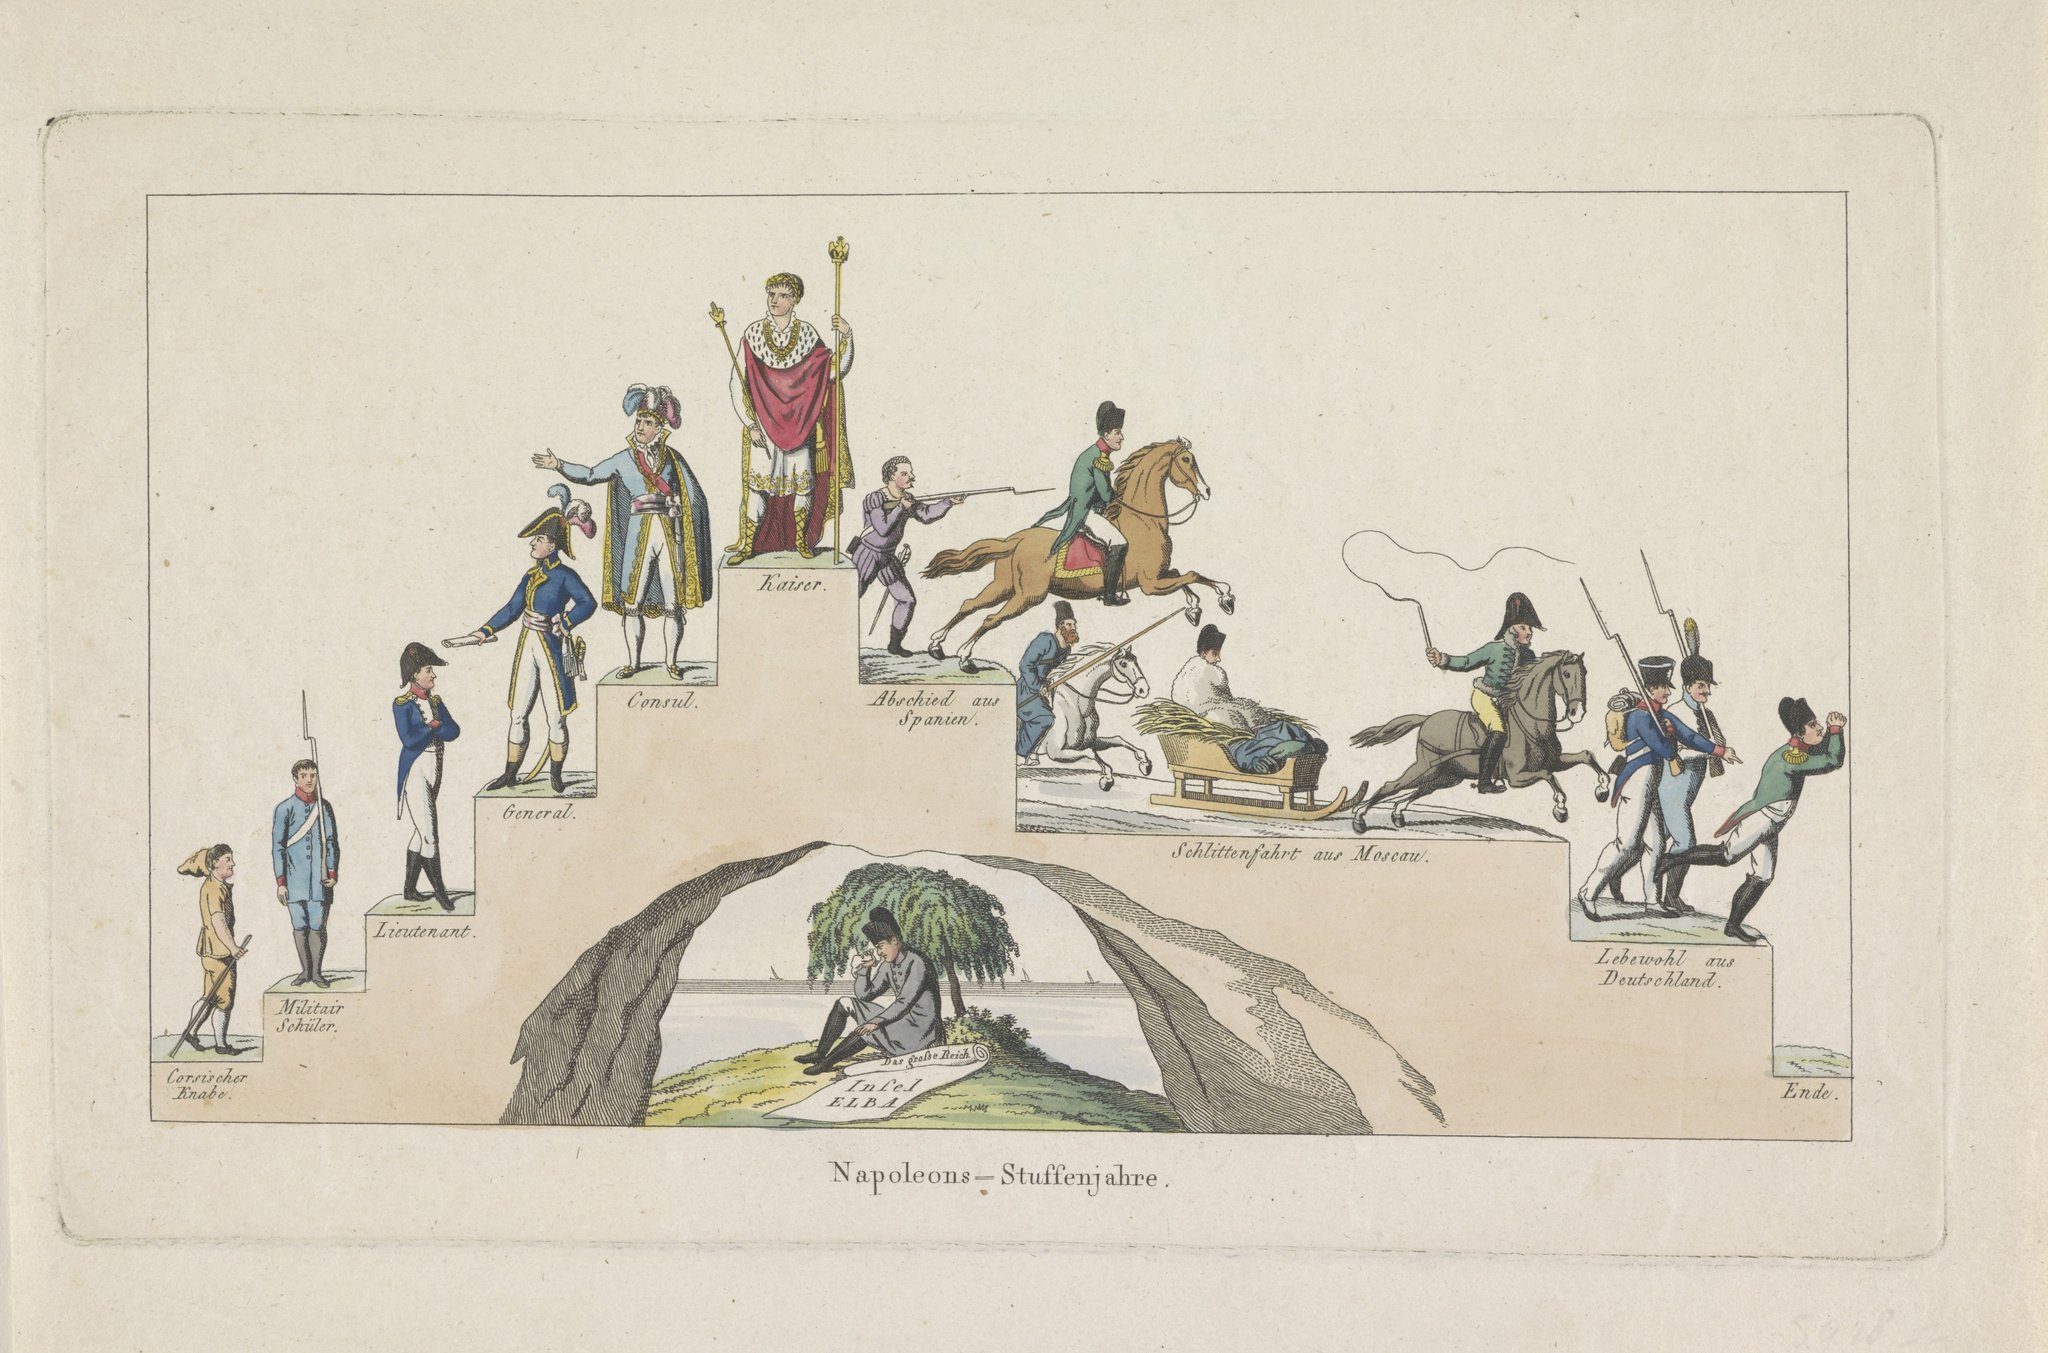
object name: print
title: Napoleons levenstrap, 1814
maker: Anonymous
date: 1814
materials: paper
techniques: etching, hand coloring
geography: germany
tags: napoleon i (emperor of the french), the ages of man represented by a staircase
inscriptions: collector's mark: Lugt 2228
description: De levenstrap van Napoleon. Beginnend links onderaan als Corsicaanse knaap werkt hij zich op tot generaal, consul en tenslotte bovenaan op zijn hoogtepunt tot keizer. Daarna gaat het trapafwaarts met nederlagen in Spanje, Moskou en Duitsland (Leipzig) in 1813. Onderaan is door een boog Napoleon te zien verbannen op het eiland Elba, 1814.